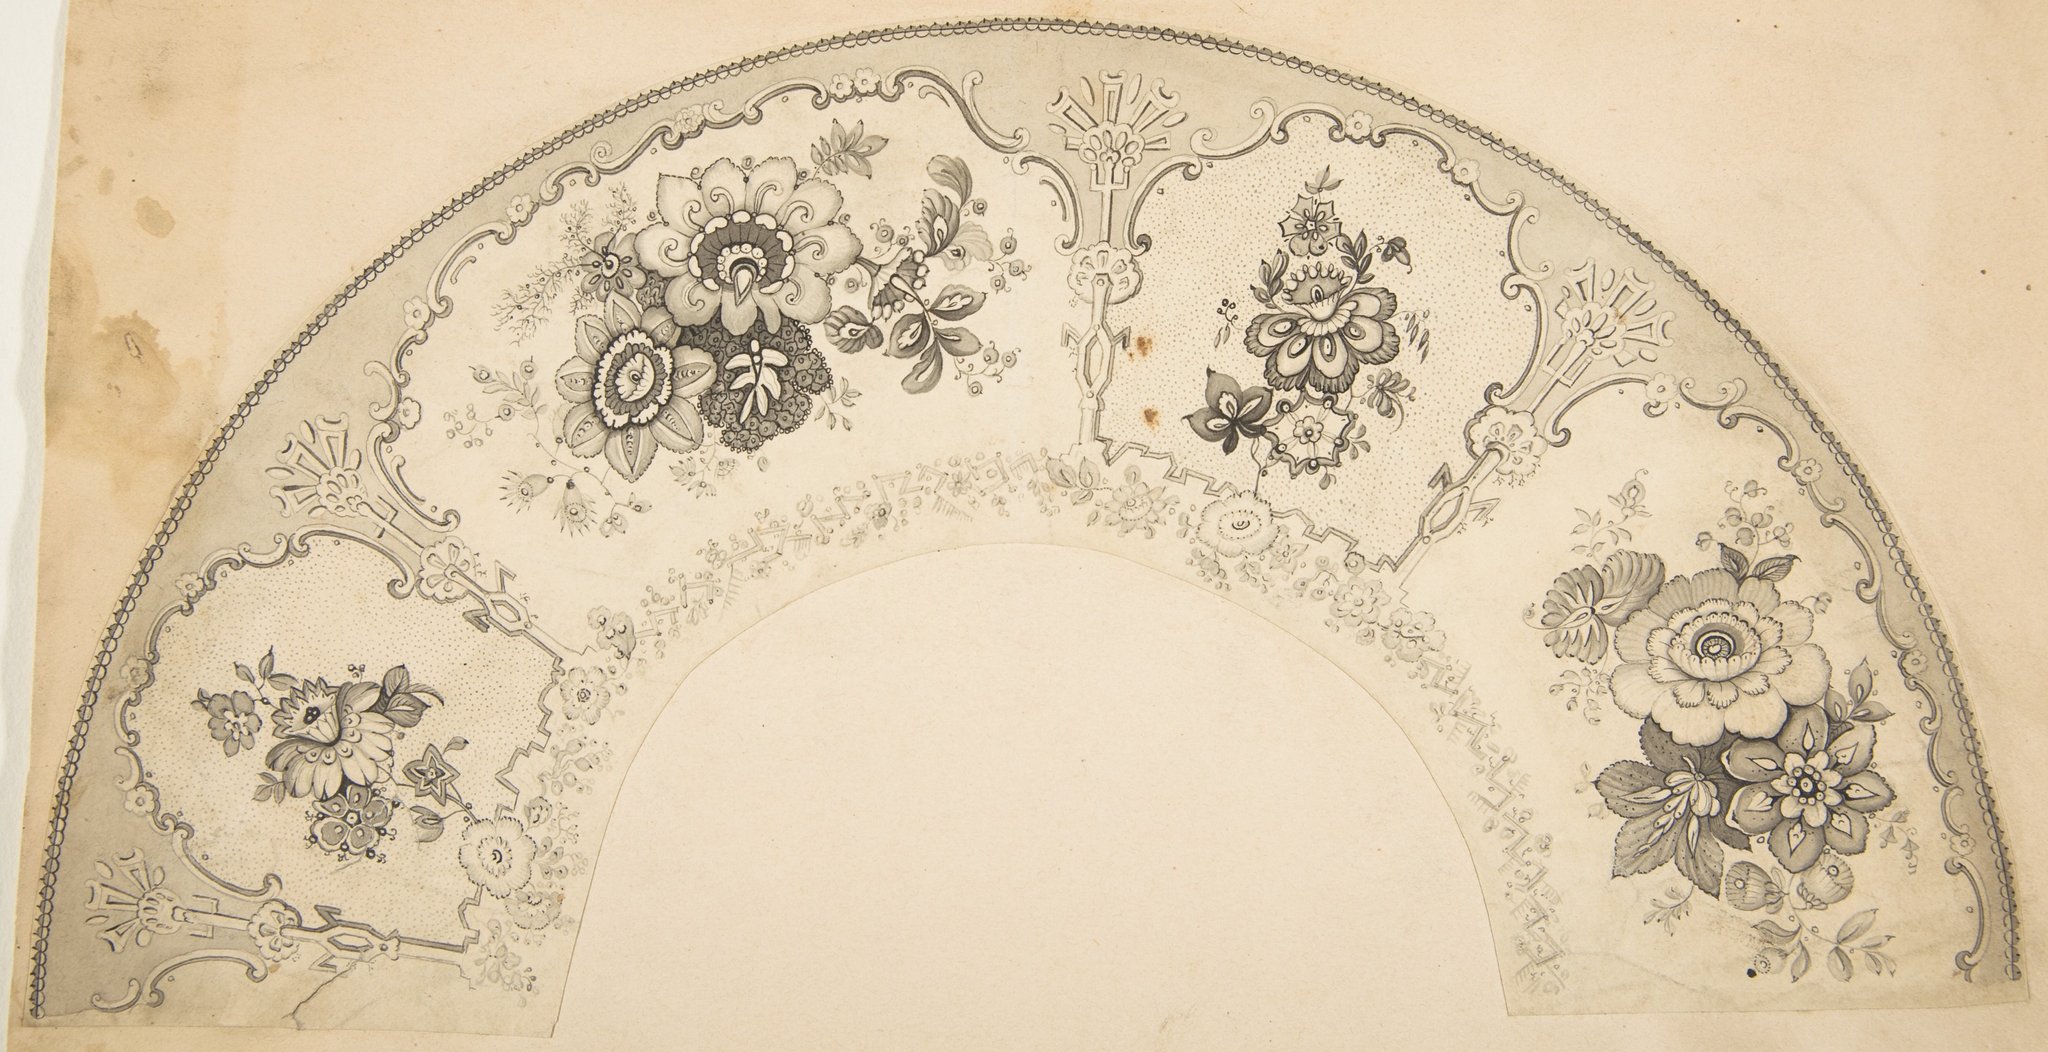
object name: drawing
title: Lace Design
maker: anonymous, french, 19th century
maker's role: artist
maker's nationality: french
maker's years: 1800-1900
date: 1801-1900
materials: ink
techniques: pen, wash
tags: flowers